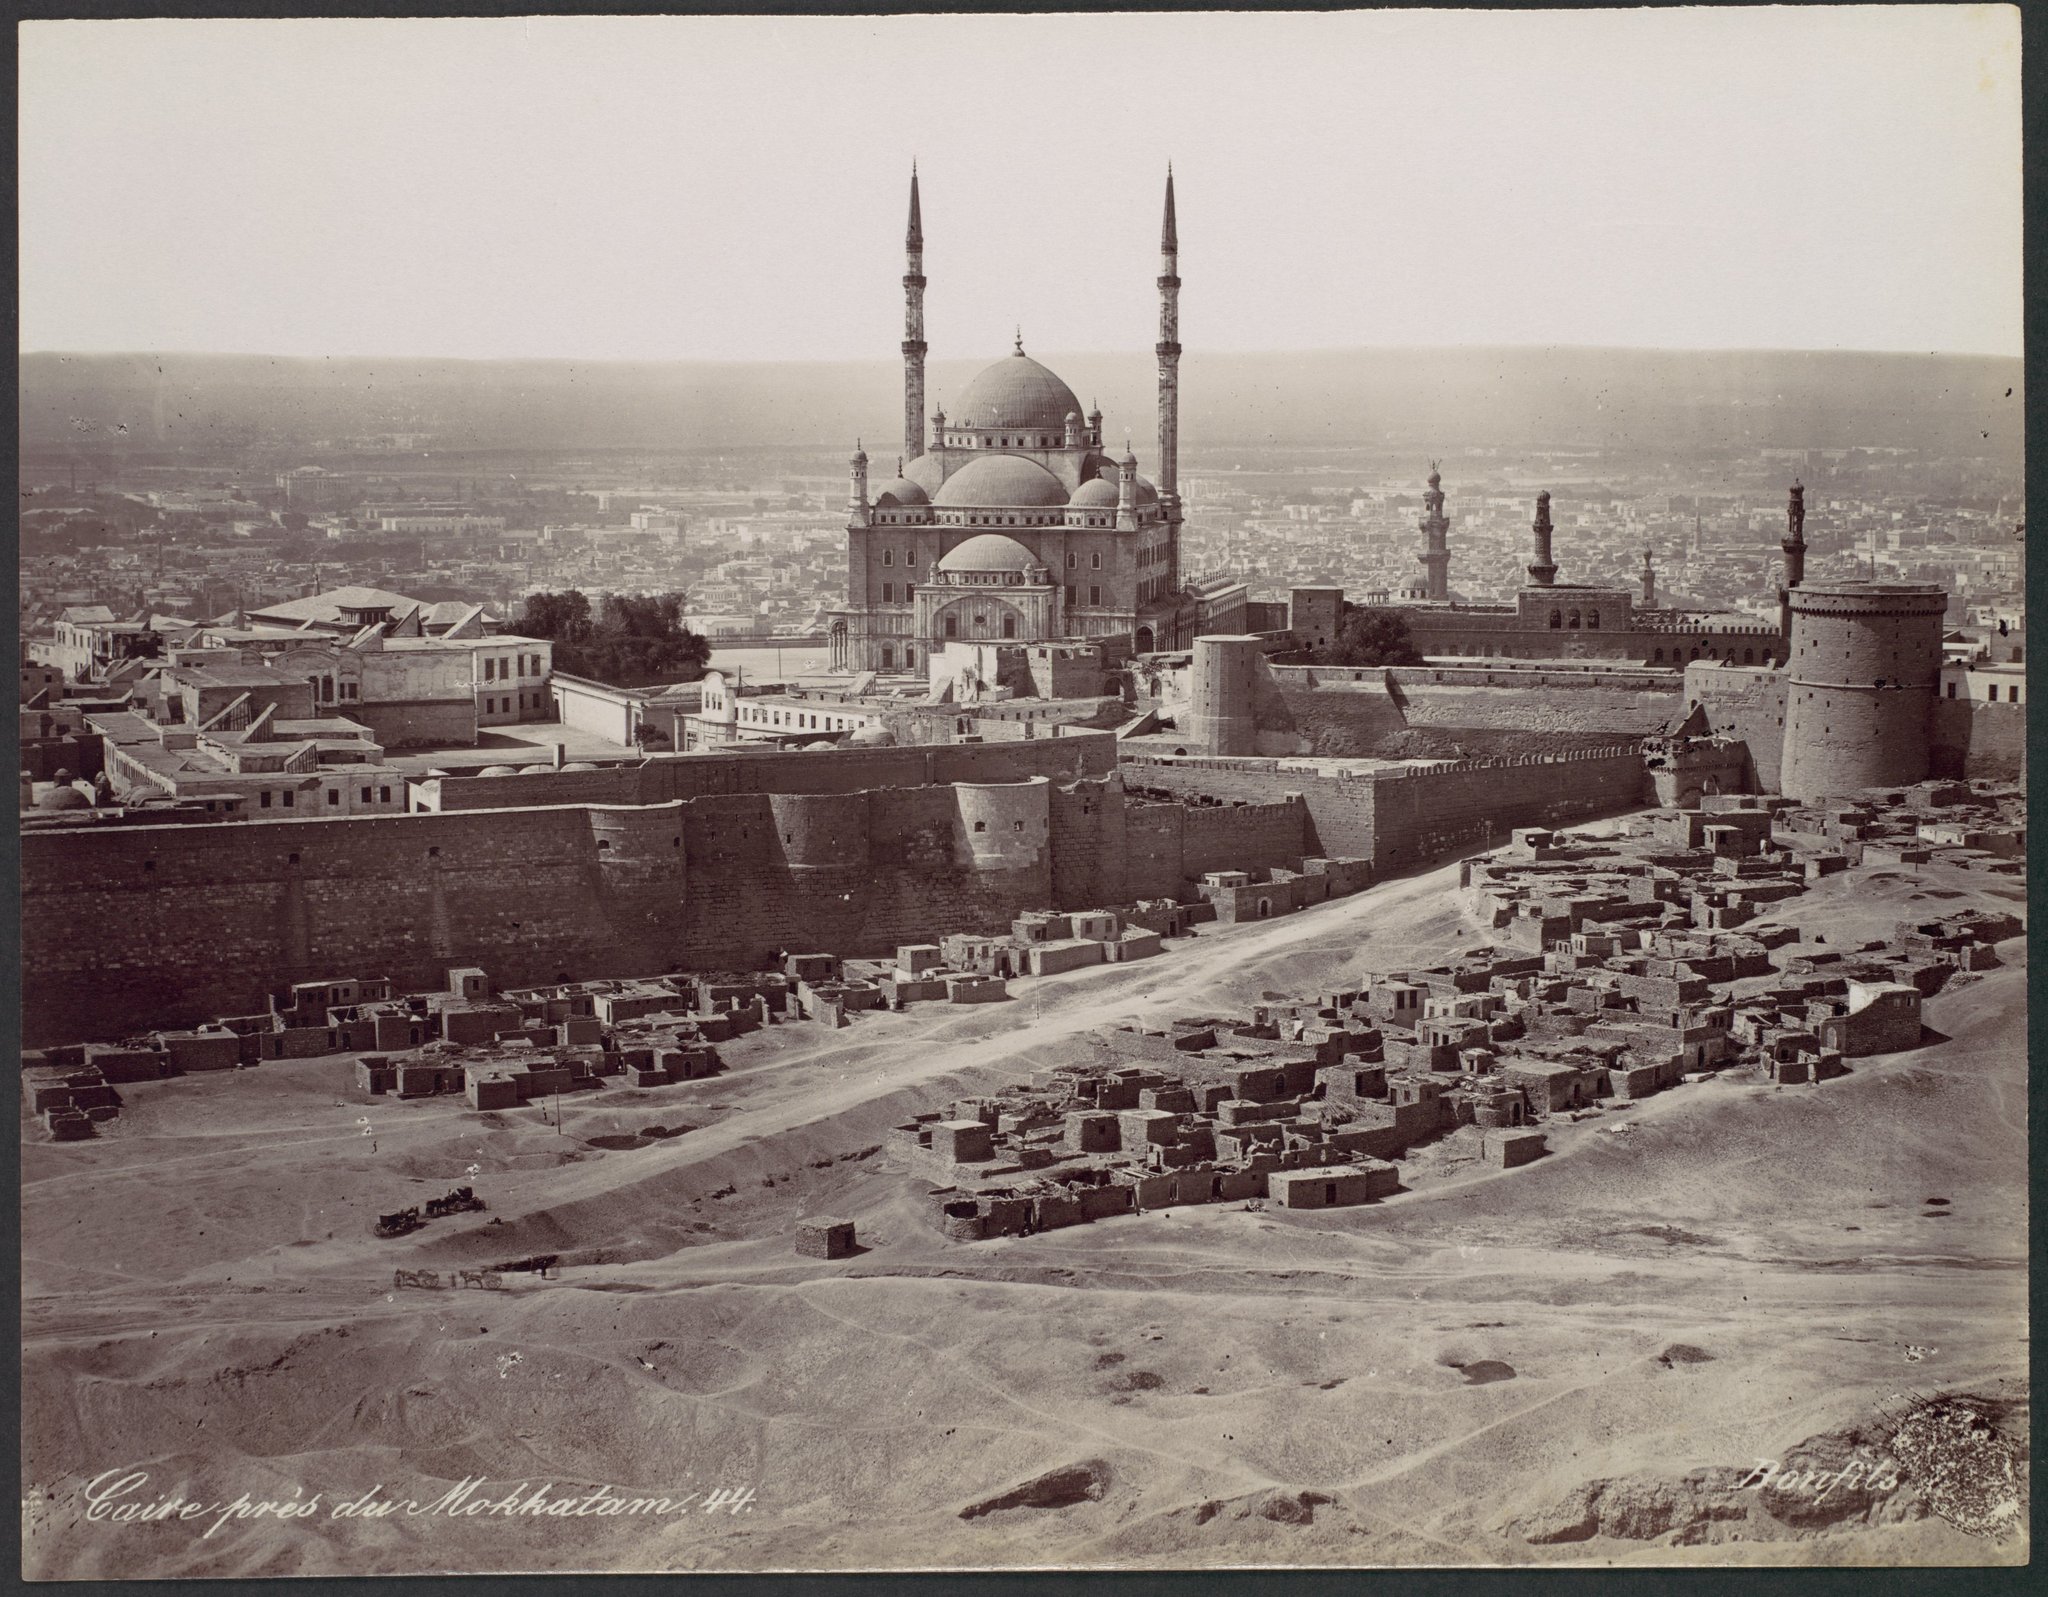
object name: photograph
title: Caire près du Mokkatam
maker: félix bonfils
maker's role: fotograaf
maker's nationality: french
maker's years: 1831-1885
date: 1870-1879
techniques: albumen silver print, glass negative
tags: architecture